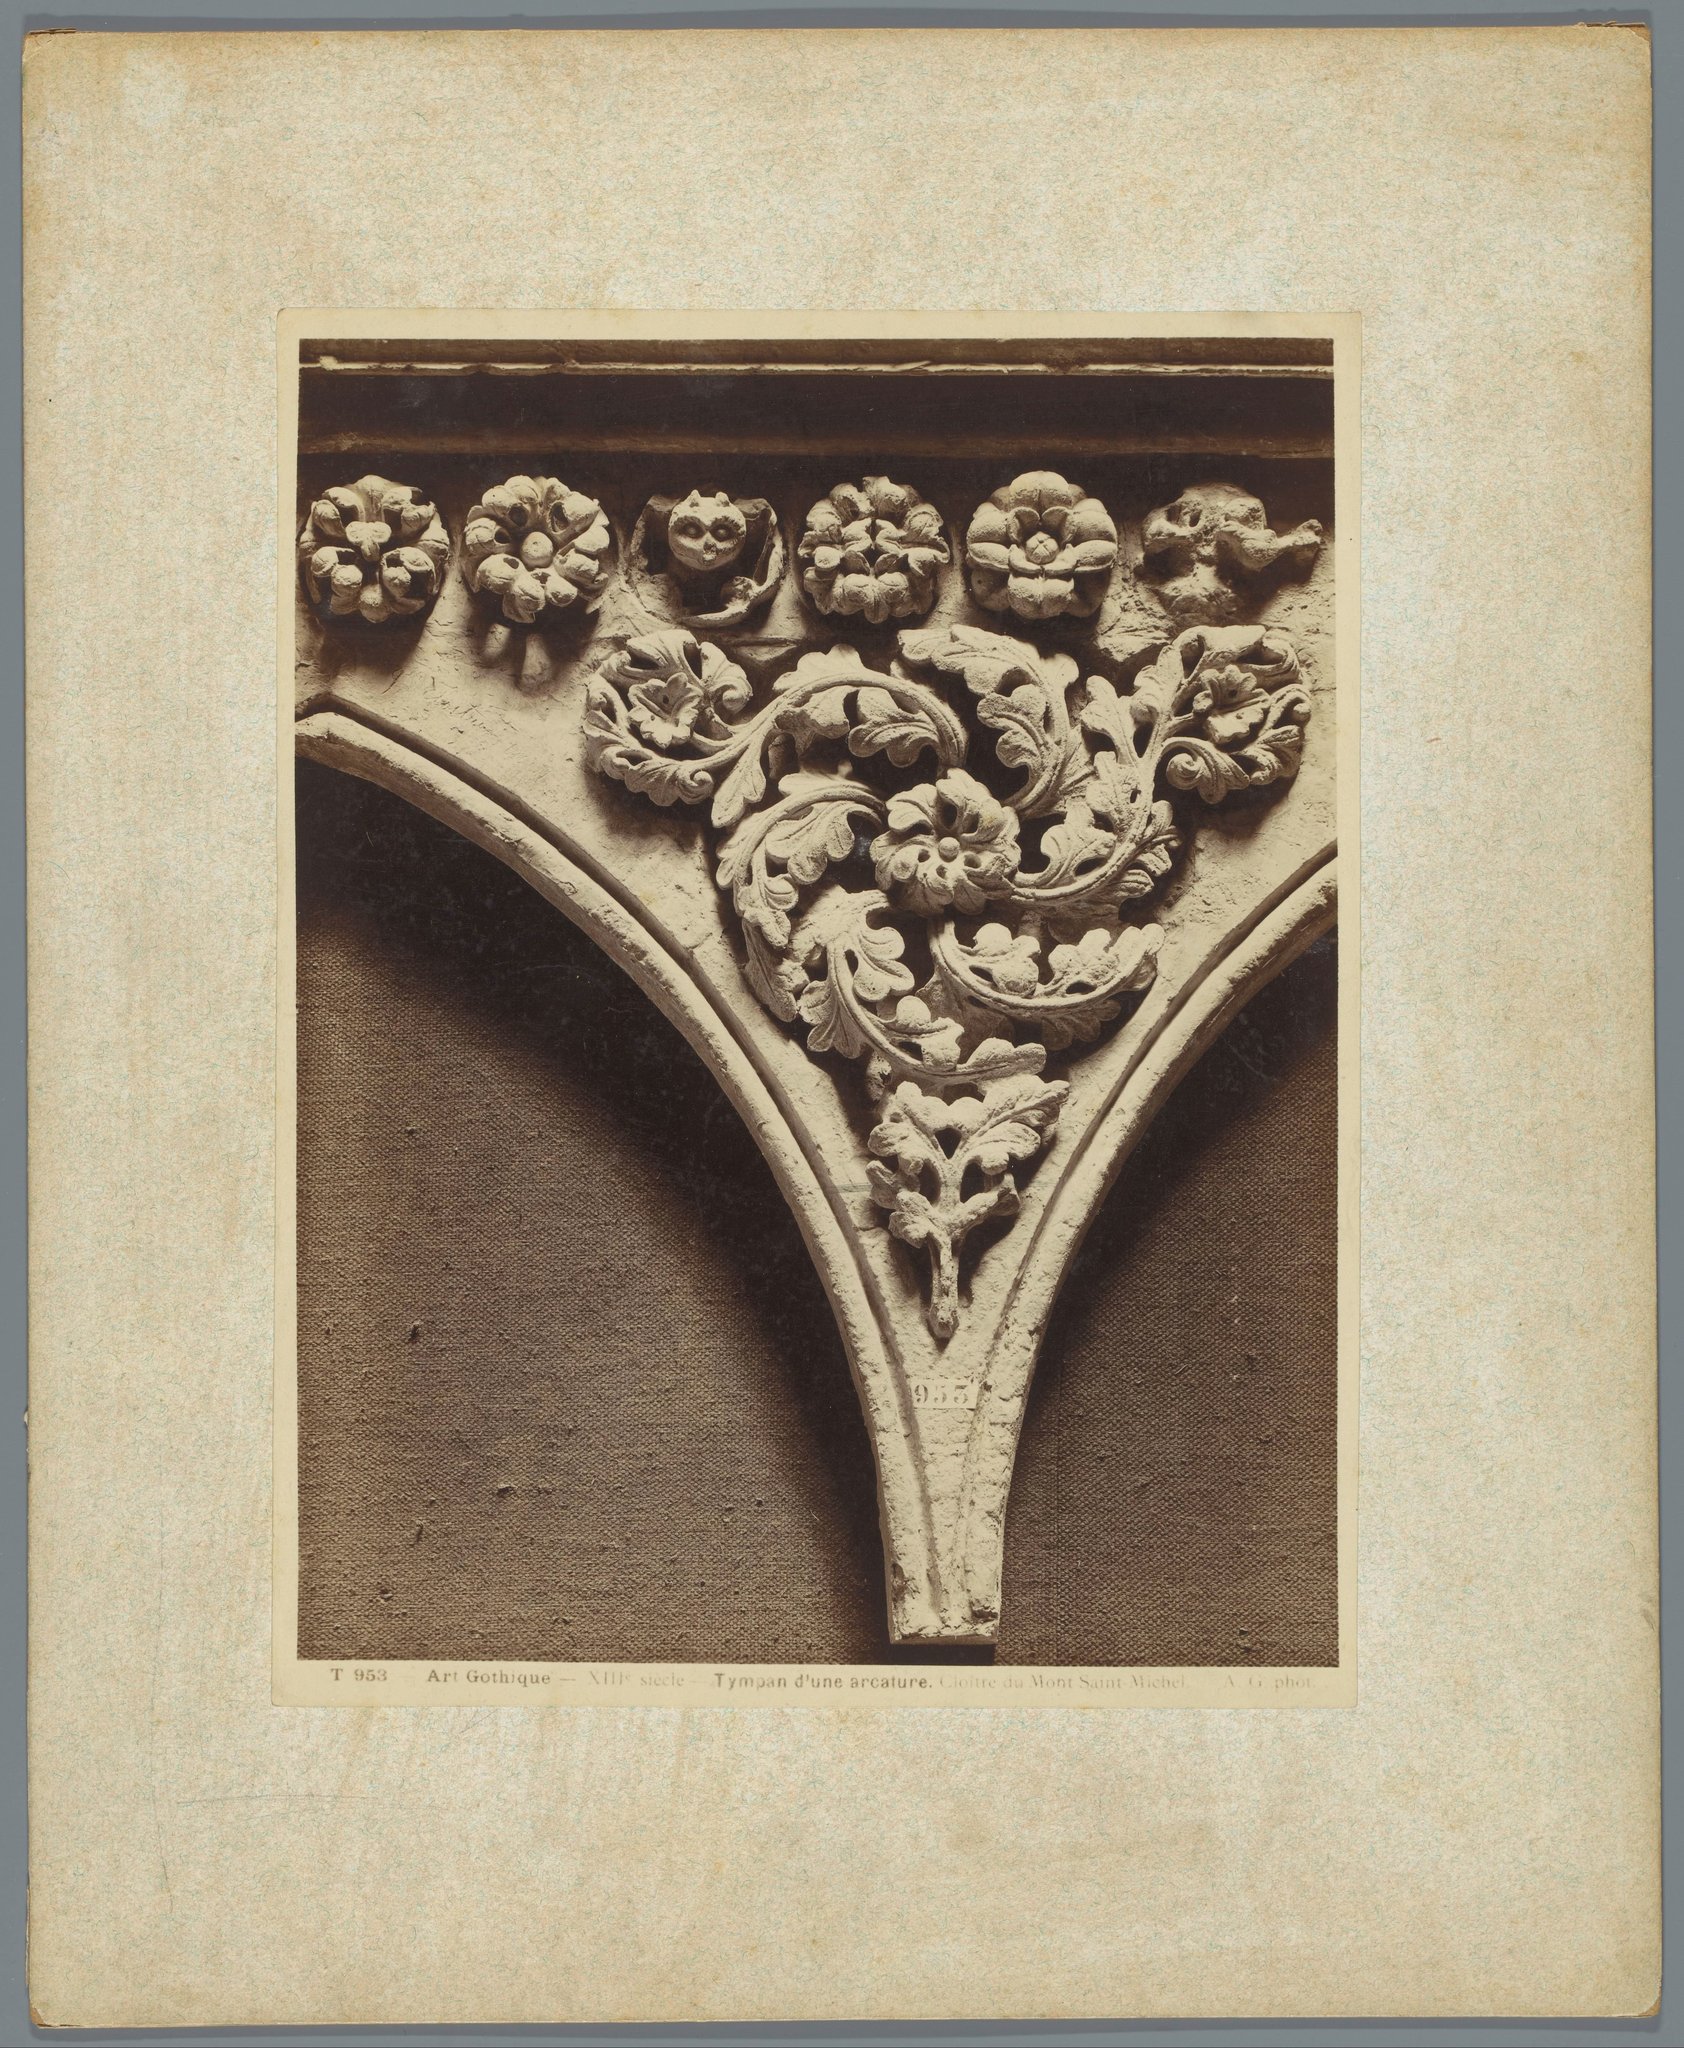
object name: photograph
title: Art Gothique - XIIIe diècle - Tympan d'une arcature. Cloître de Mont Saint-Michel.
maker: adolphe giraudon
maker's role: publisher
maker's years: 1849-1929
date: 1875-1900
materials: cardboard, photographic support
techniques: albumen print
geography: france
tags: flowers ~ ornament, sculpture (+ relief ~ sculpture)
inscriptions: collector's mark: ‘RIJKS-NORMAALSCHOOL voor TEEKENONDERWIJZERS AMSTERDAM’, name: ‘A. GIRAUDON ÉDITEUR 15, R. BONAPARTE, PARIS’, number: ‘T 953’